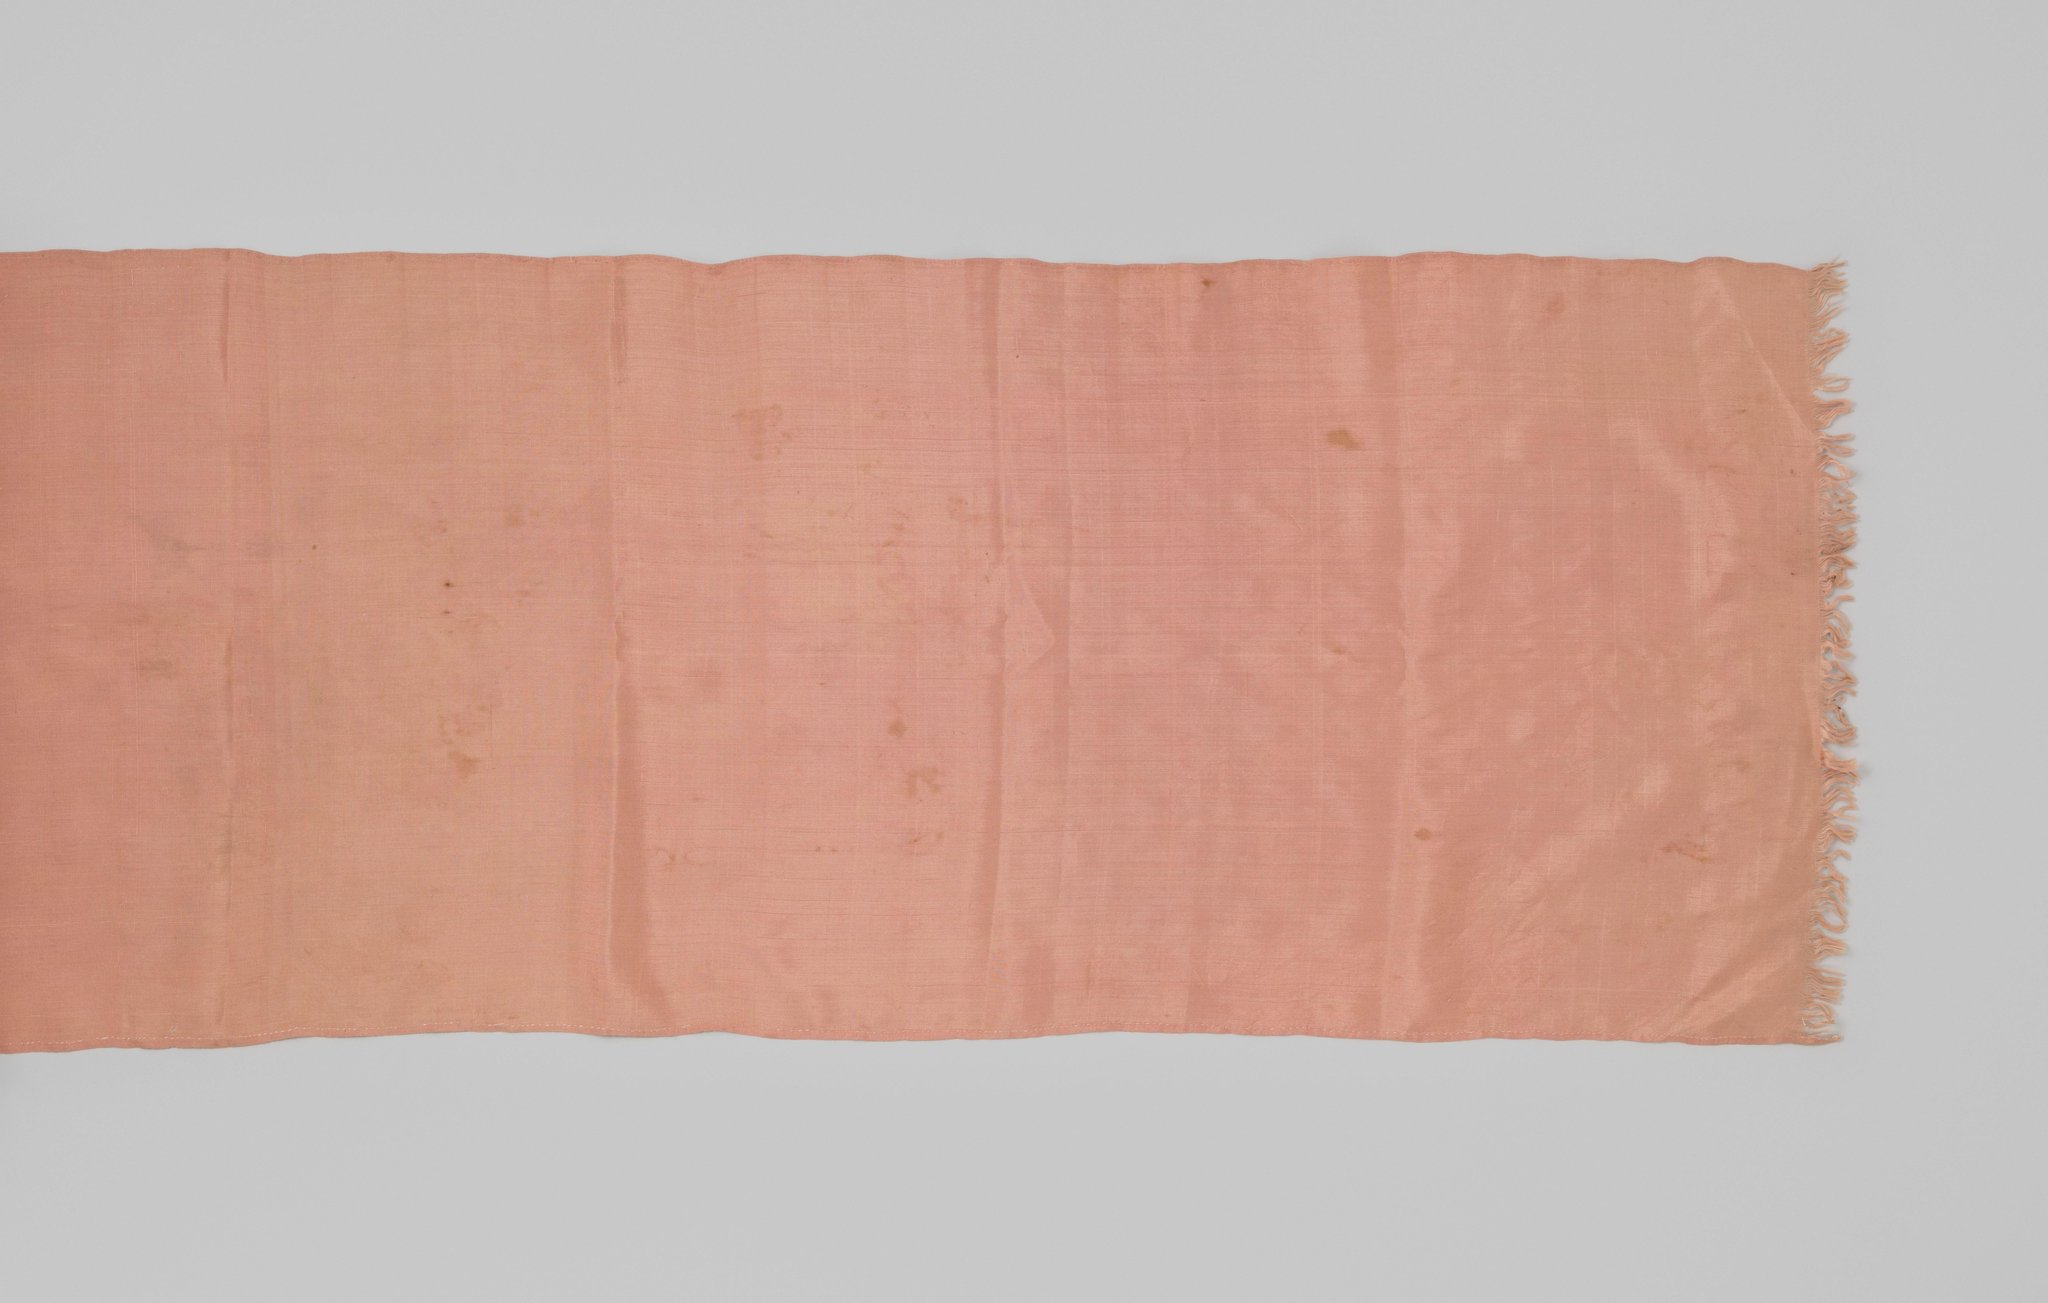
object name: ribbon material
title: Ceintuurlint van zalmroze tafzijde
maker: Anonymous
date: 1908-1910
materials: textile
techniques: weave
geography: china